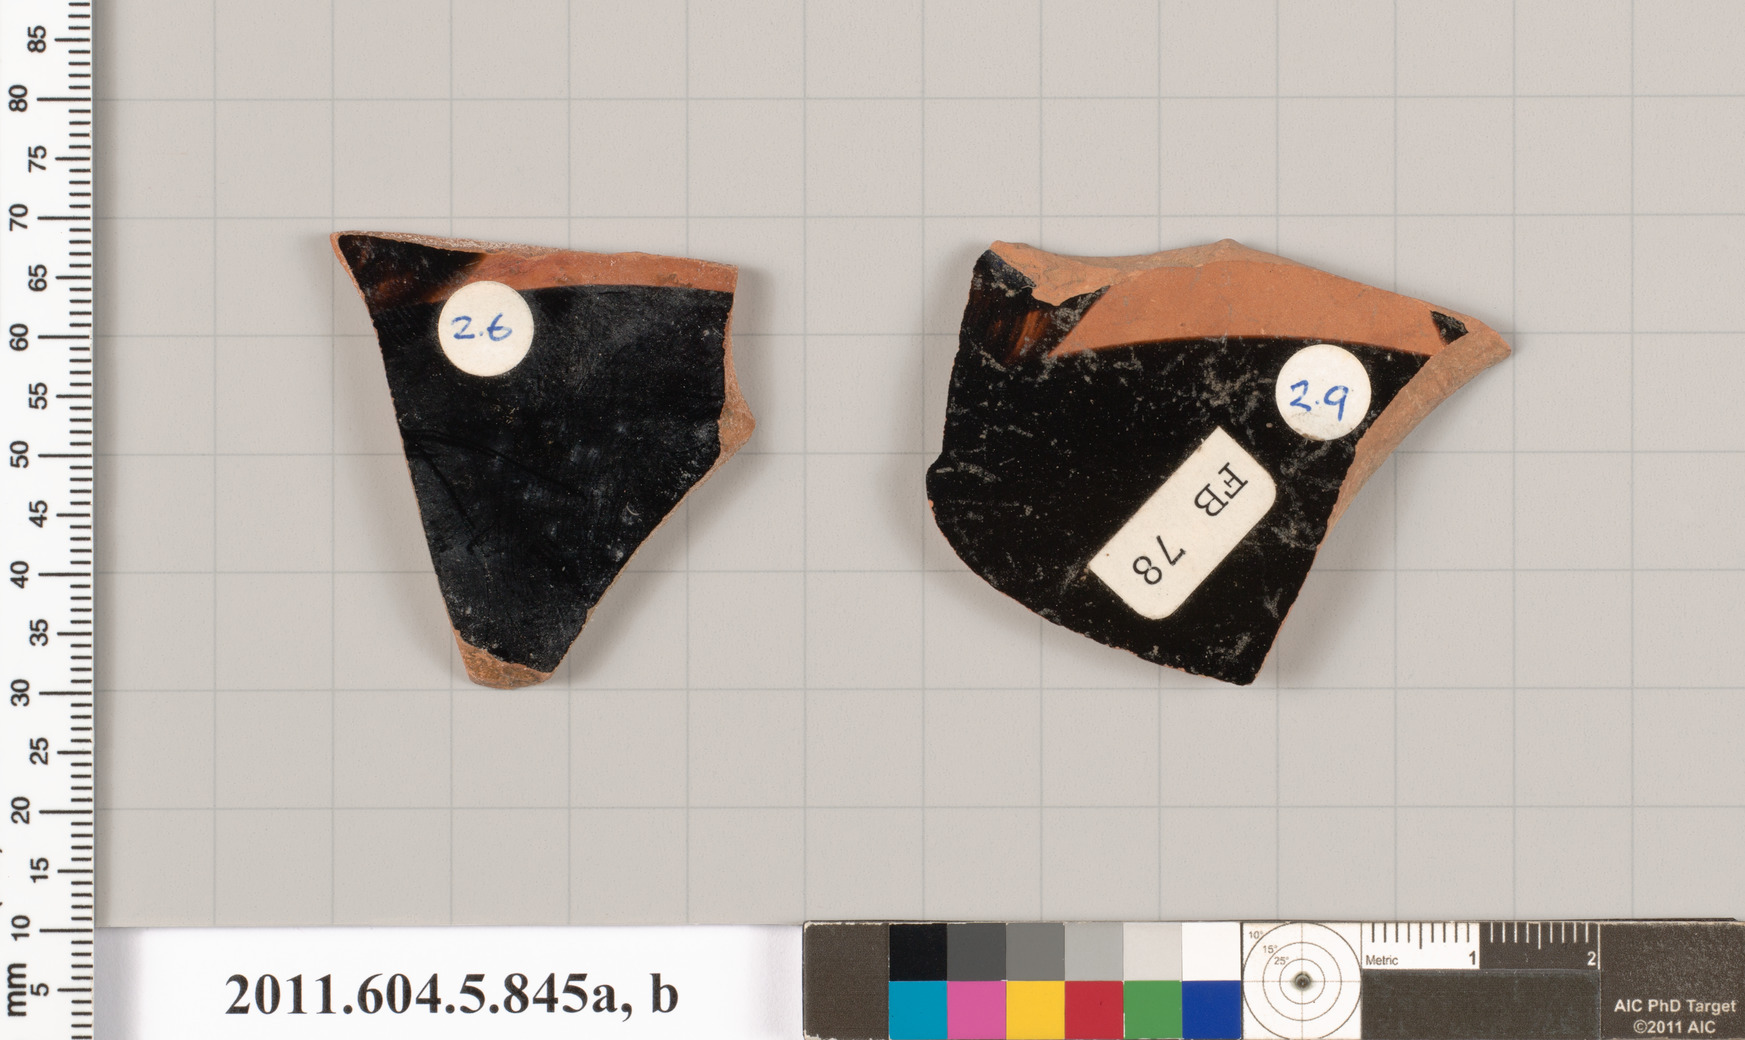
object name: kylix fragment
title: Terracotta fragments of kylikes (drinking cups)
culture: greek, attic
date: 600-401 BCE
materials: terracotta